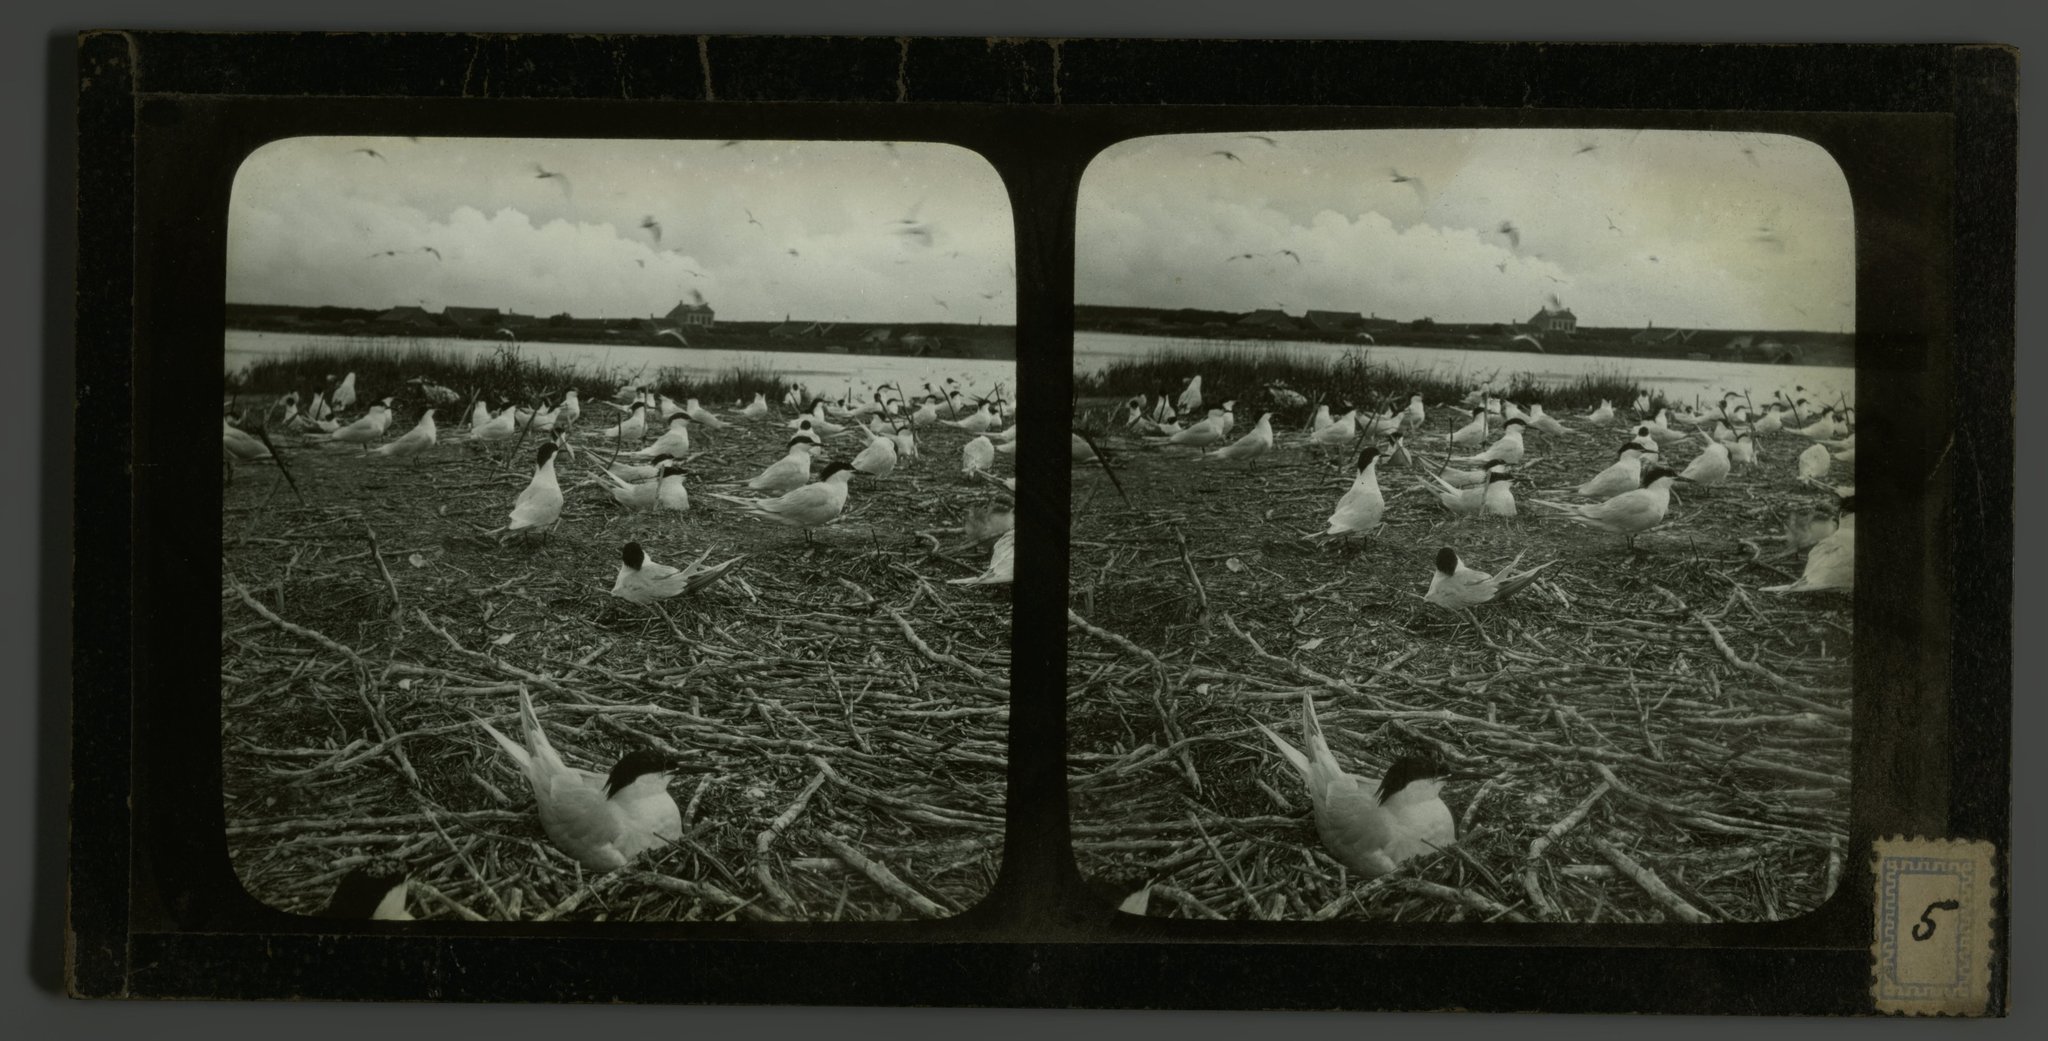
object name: stereoscopic photograph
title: Broedende kolonie sternen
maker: Anonymous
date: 1856-1890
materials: glass, paper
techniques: slide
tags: water-birds (+ brooding, hatching)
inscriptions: number: ‘5’